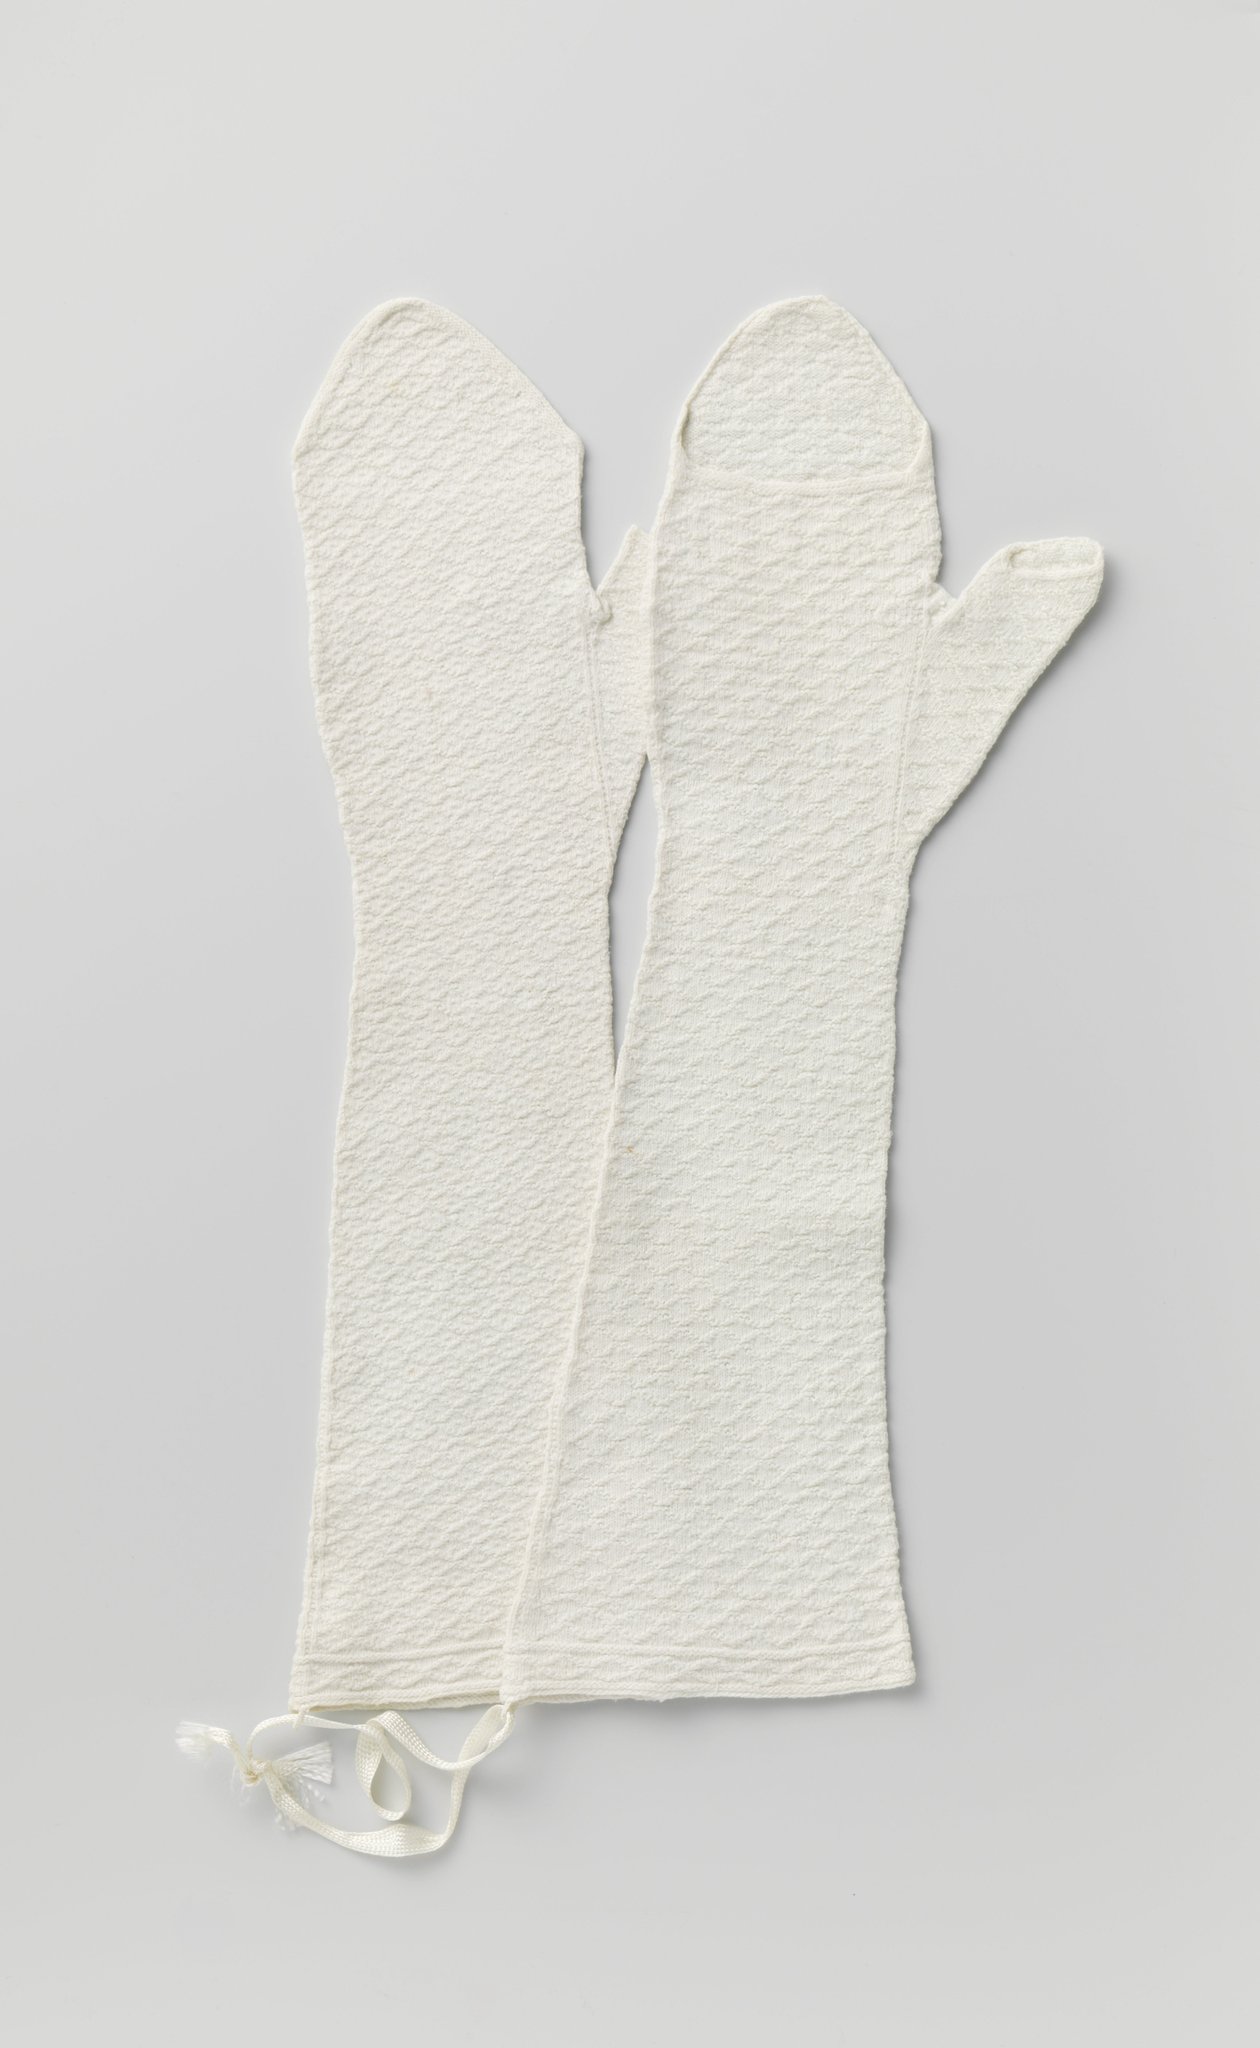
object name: clothing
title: Mitaine van witte gebreide katoen met open duim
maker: Anonymous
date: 1730-1800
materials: cotton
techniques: knitting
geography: western europe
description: Linkermitaine van witte gebreide katoen in ruitjespatroon. Met een open duim. De handrug heeft een onversierde gladde rand.